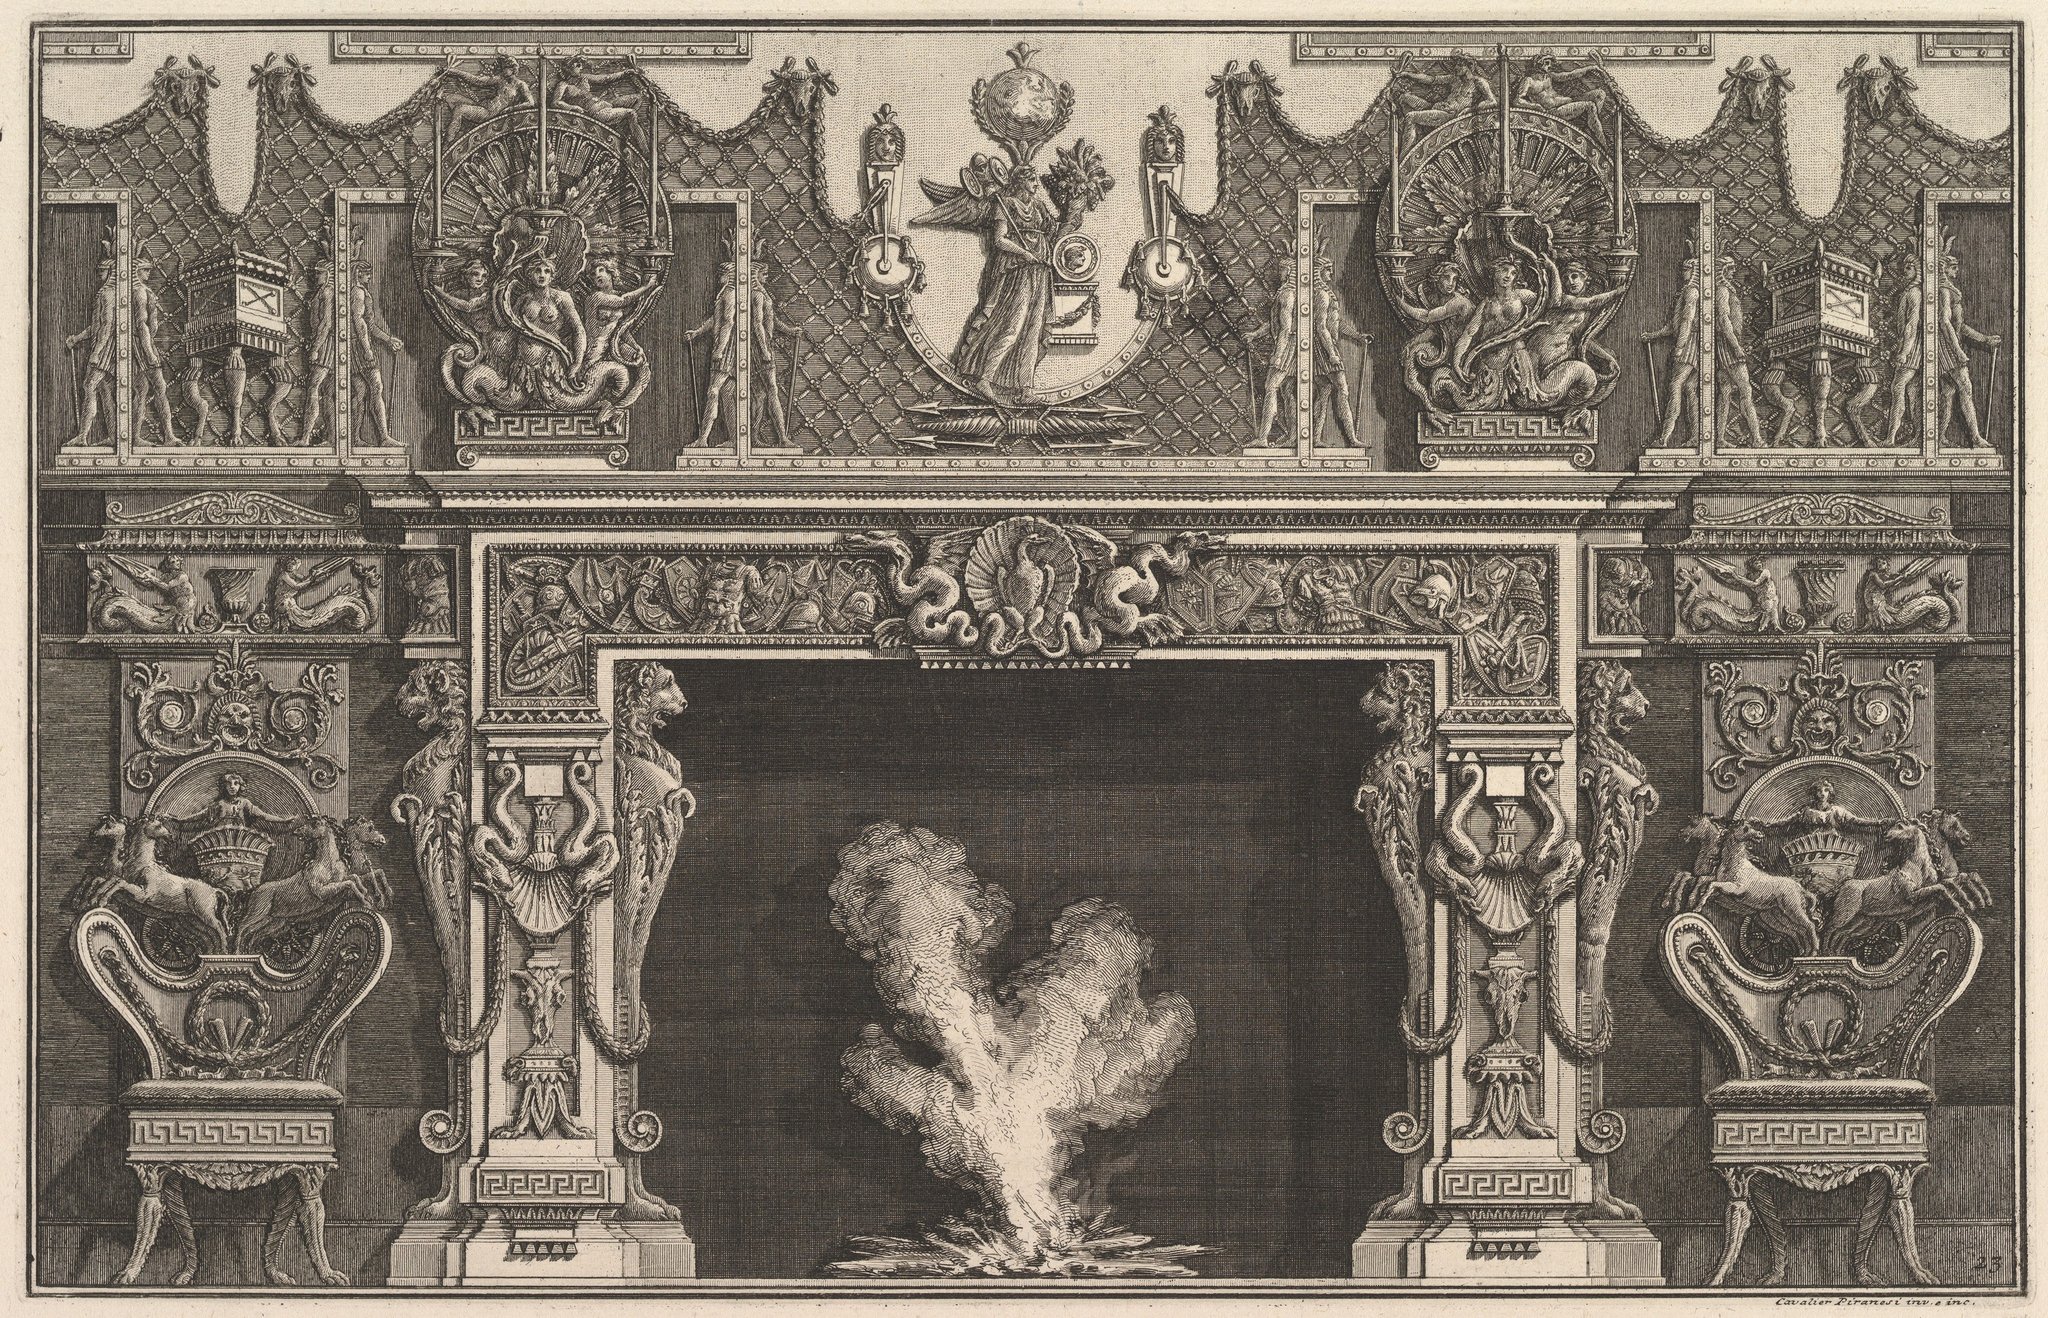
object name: print ornament architecture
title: Bird in shell at the center of the lintel, with a frieze of trophies, surmounted by an overmantel with candelabra and flanked by chairs. (Ch. décorée d'une frise de casques et d'armures . . .)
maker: giovanni battista piranesi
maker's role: artist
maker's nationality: italian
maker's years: 1720-1778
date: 1769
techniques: etching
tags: birds,fireplaces,chairs,trophies